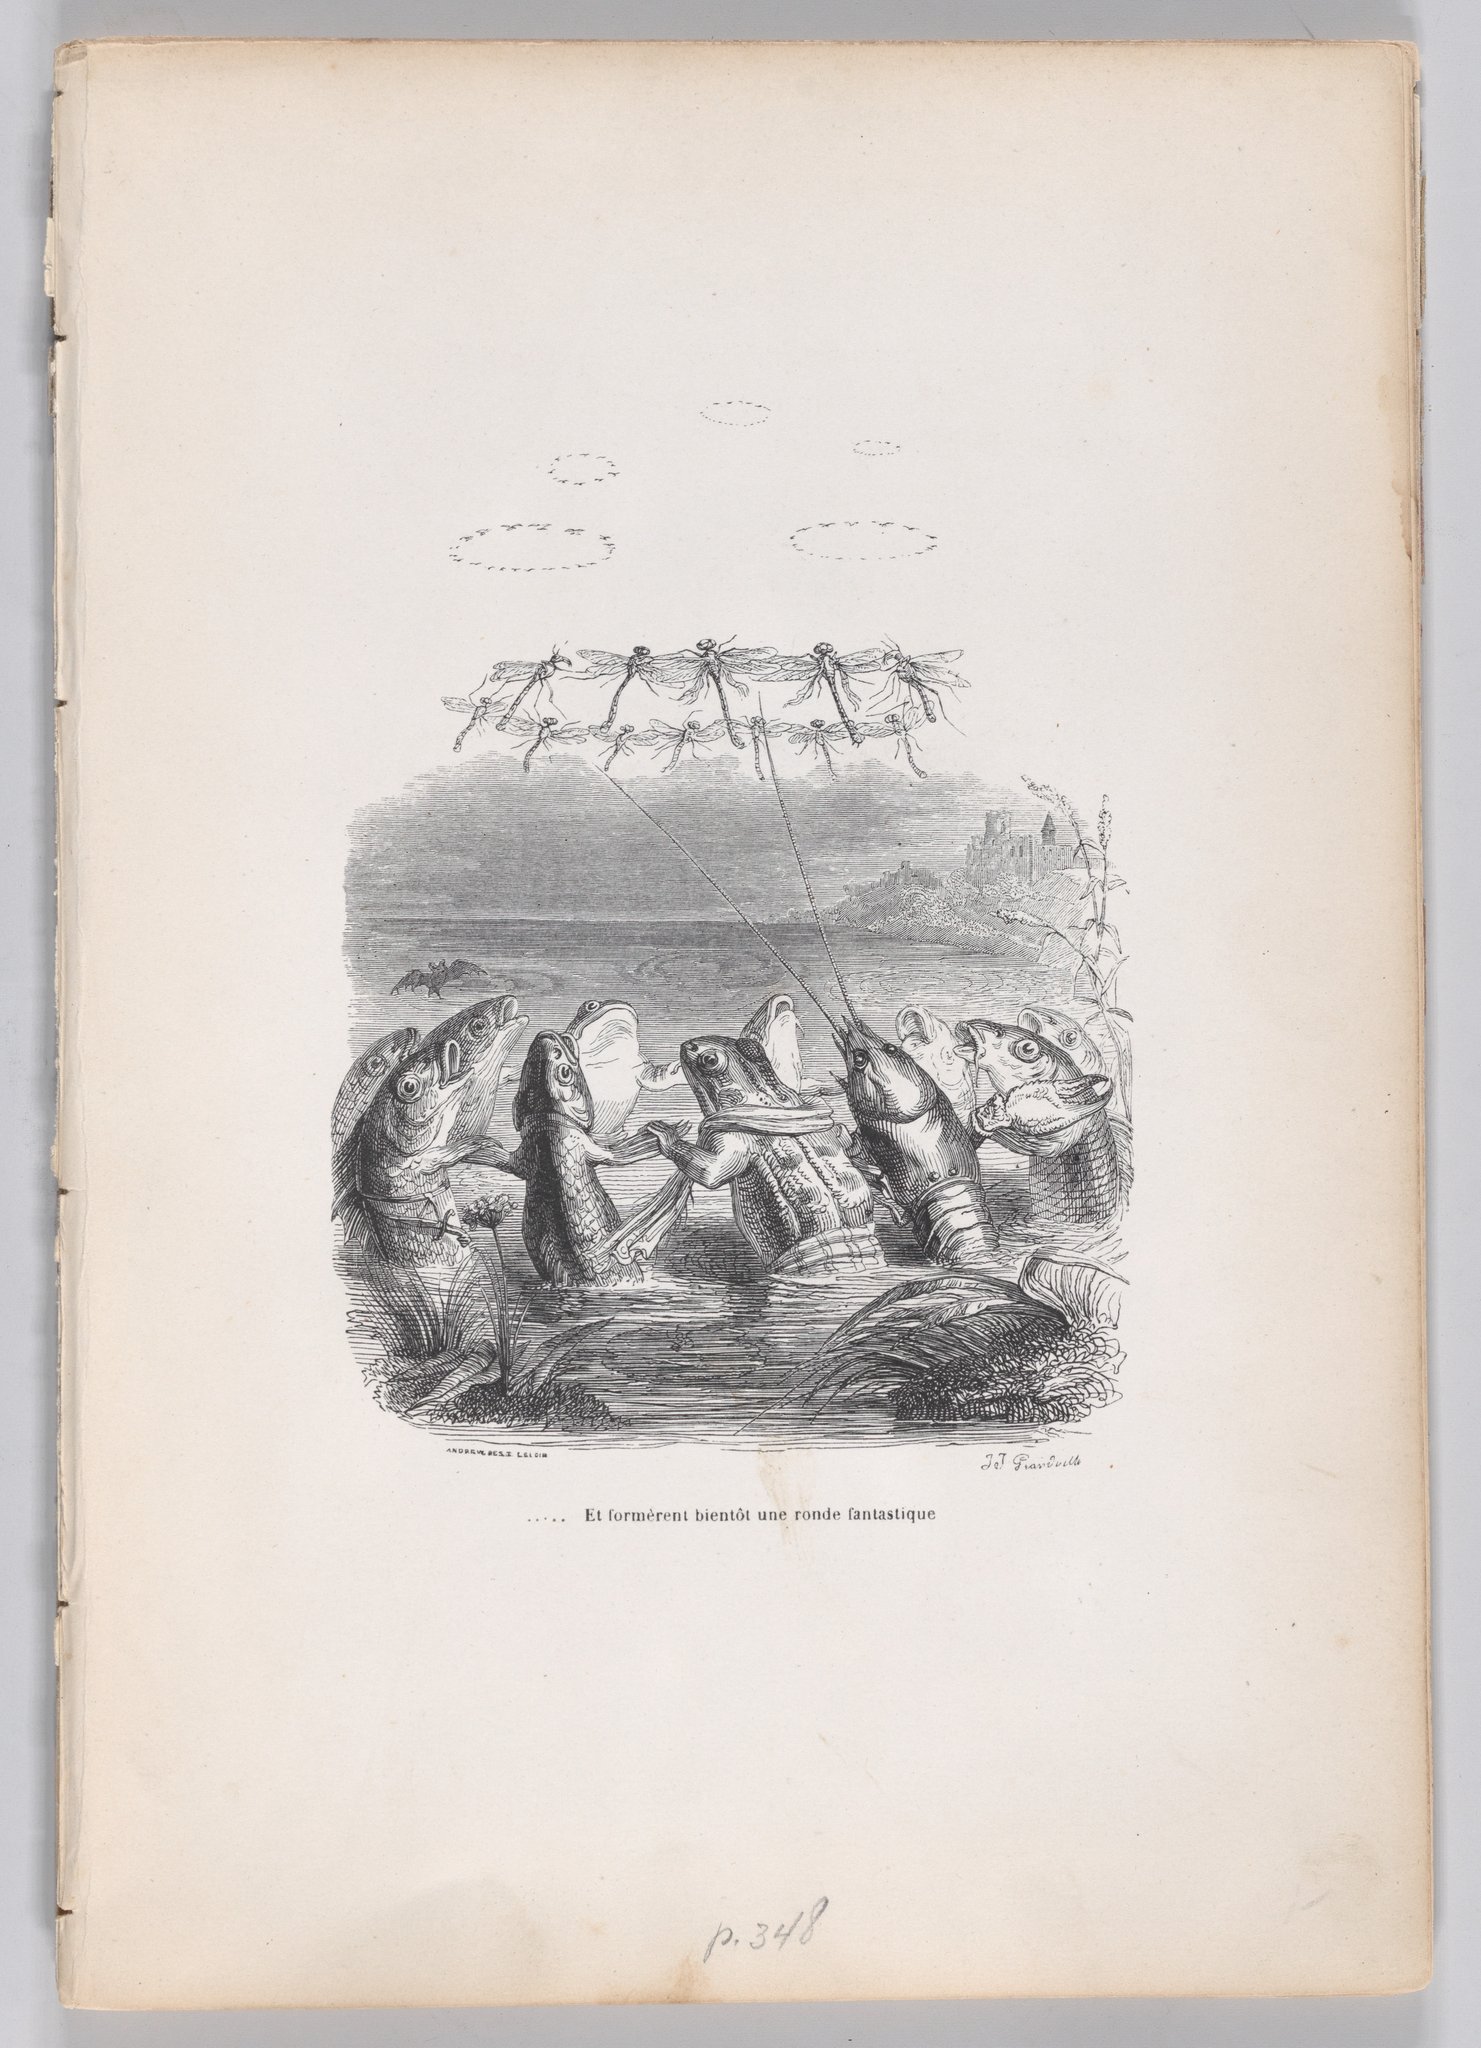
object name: print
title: ... and soon formed a fantastic round, from "Scenes from the Private and Public Life of Animals"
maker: j. j. grandville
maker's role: illustrator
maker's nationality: french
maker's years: 1803-1847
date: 1837-1847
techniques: engraving